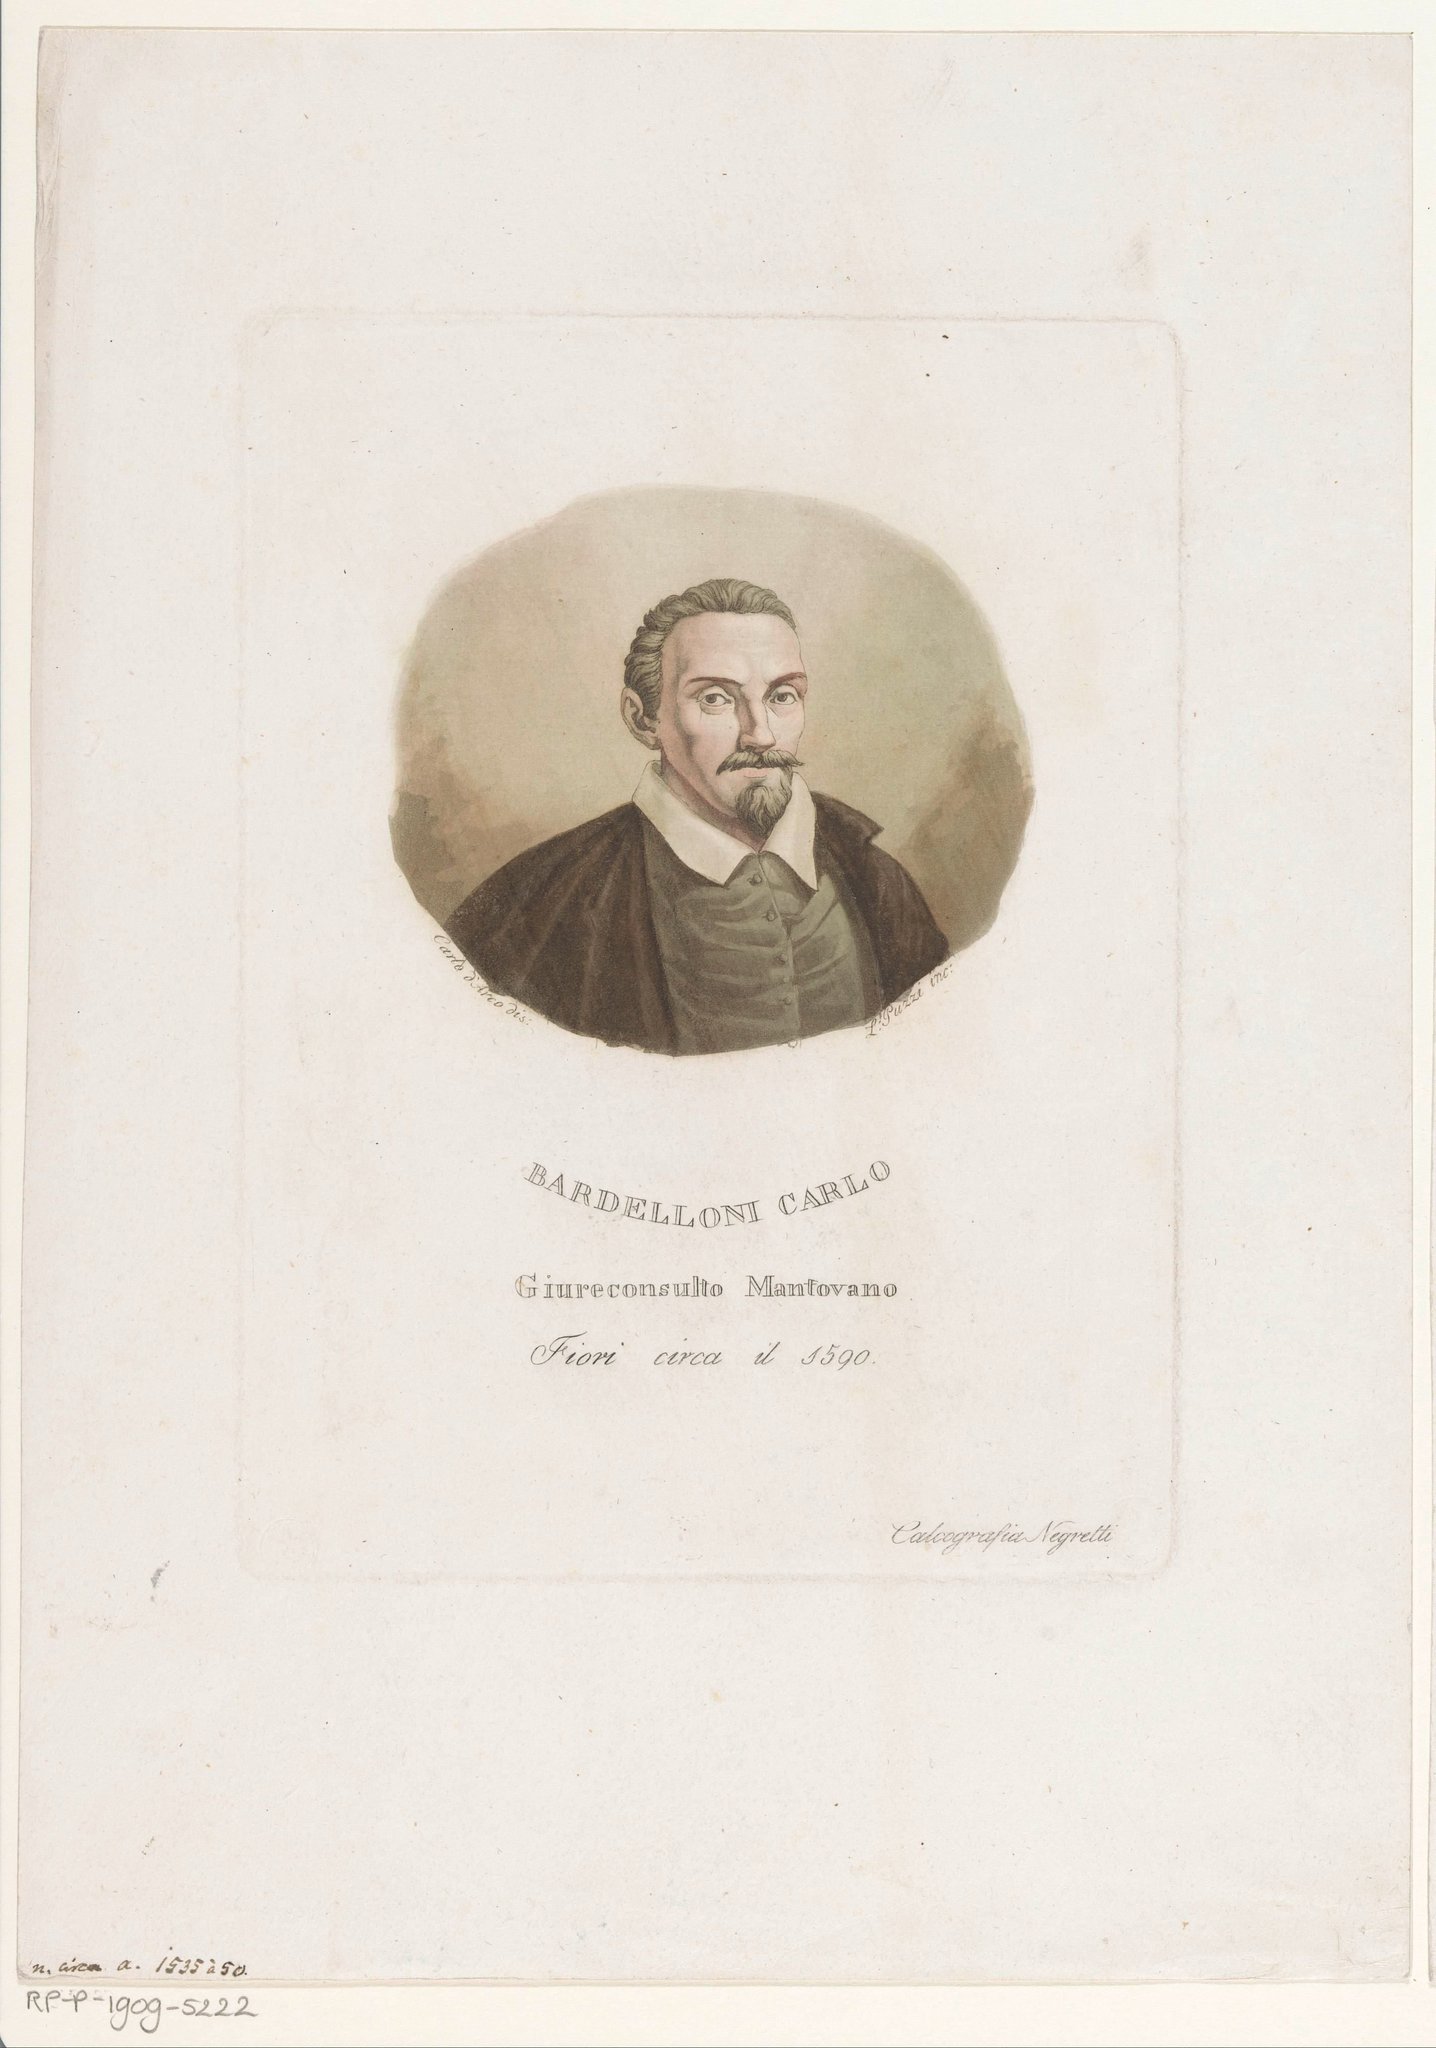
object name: print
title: Portretten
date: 1830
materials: paper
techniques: aquatint, brush, colour, etching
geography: mantua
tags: historical persons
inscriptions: collector's mark: ‘F A N’, collector's mark: ‘S A N’, collector's mark: Lugt 2228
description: Deze prent maakt deel uit van een reeks portretprenten.